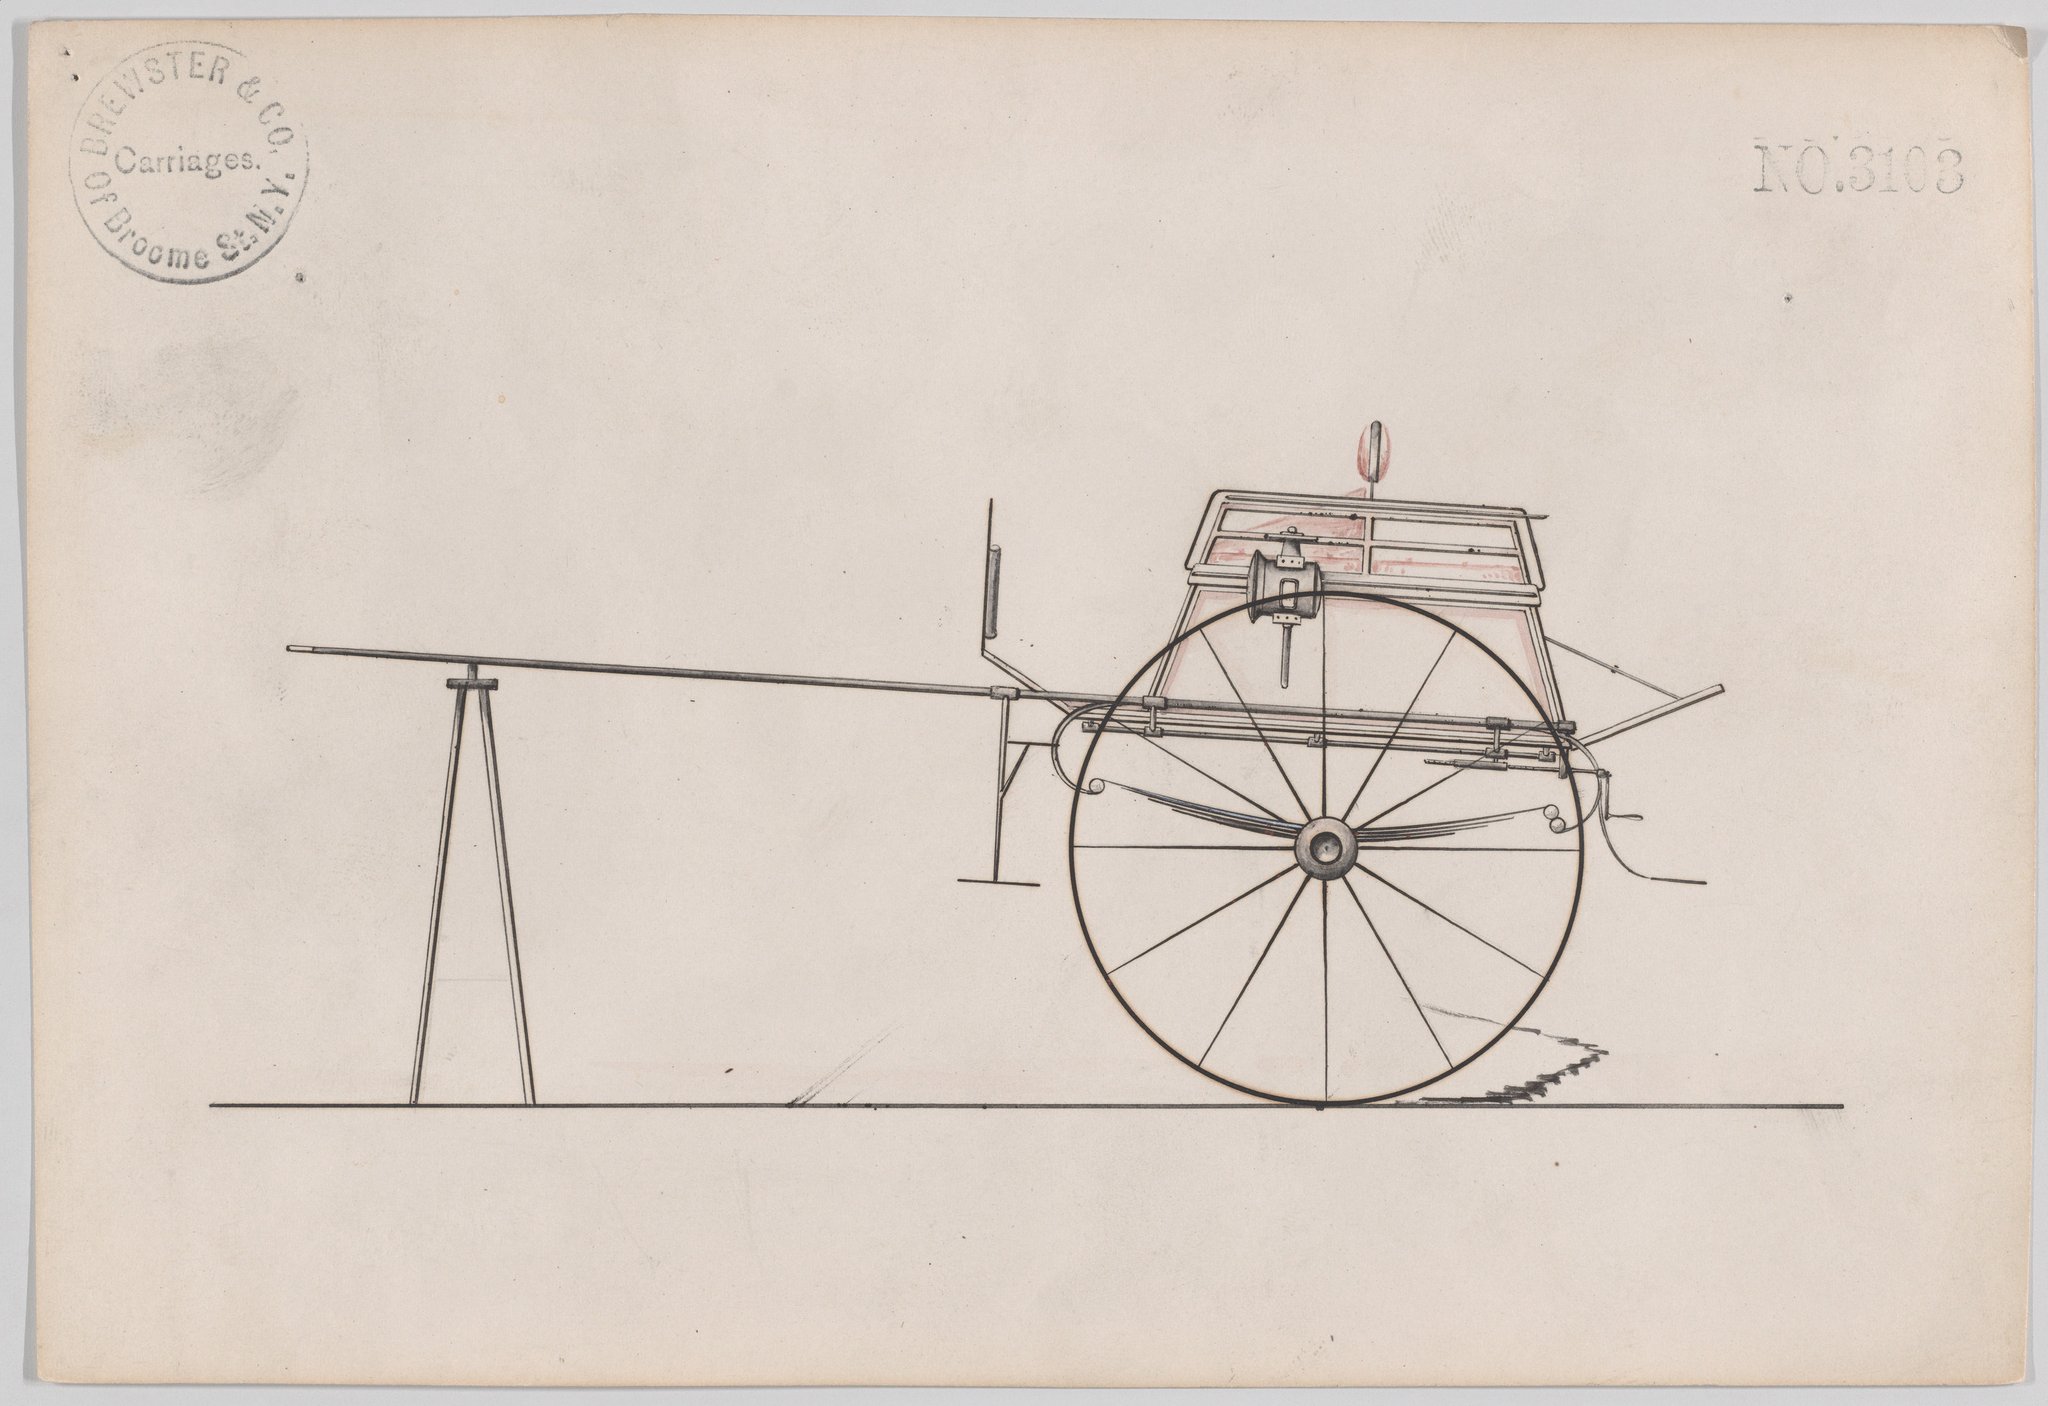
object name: drawing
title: Design for Dog Cart or 2 Wheeler, no. 3103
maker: brewster & co.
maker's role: manufacturer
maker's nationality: american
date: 1875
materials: gouache, gum arabic, ink, watercolor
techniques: pen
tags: carriages